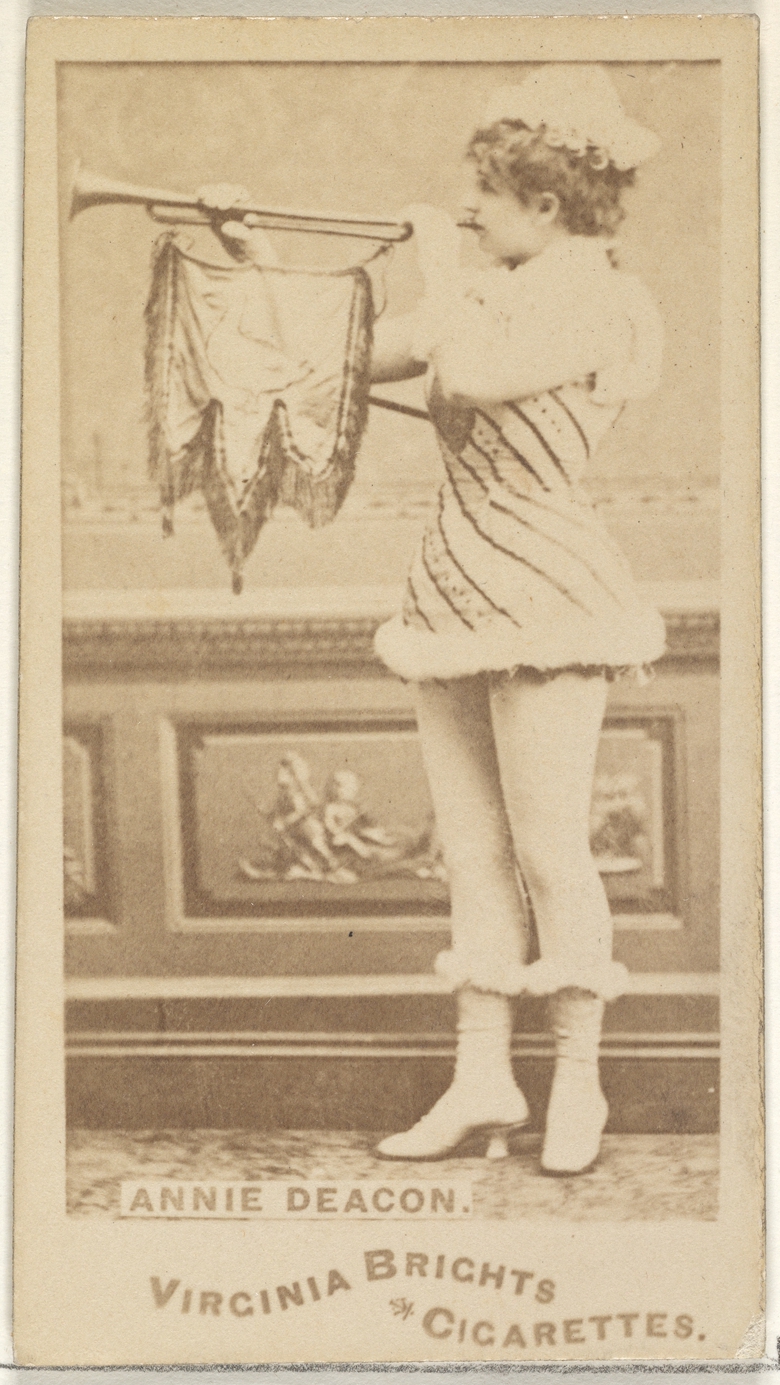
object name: photograph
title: Annie Deacon, from the Actors and Actresses series (N45, Type 1) for Virginia Brights Cigarettes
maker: allen & ginter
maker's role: publisher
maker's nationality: american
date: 1888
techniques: albumen silver print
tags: portraits,women,trumpets,actresses